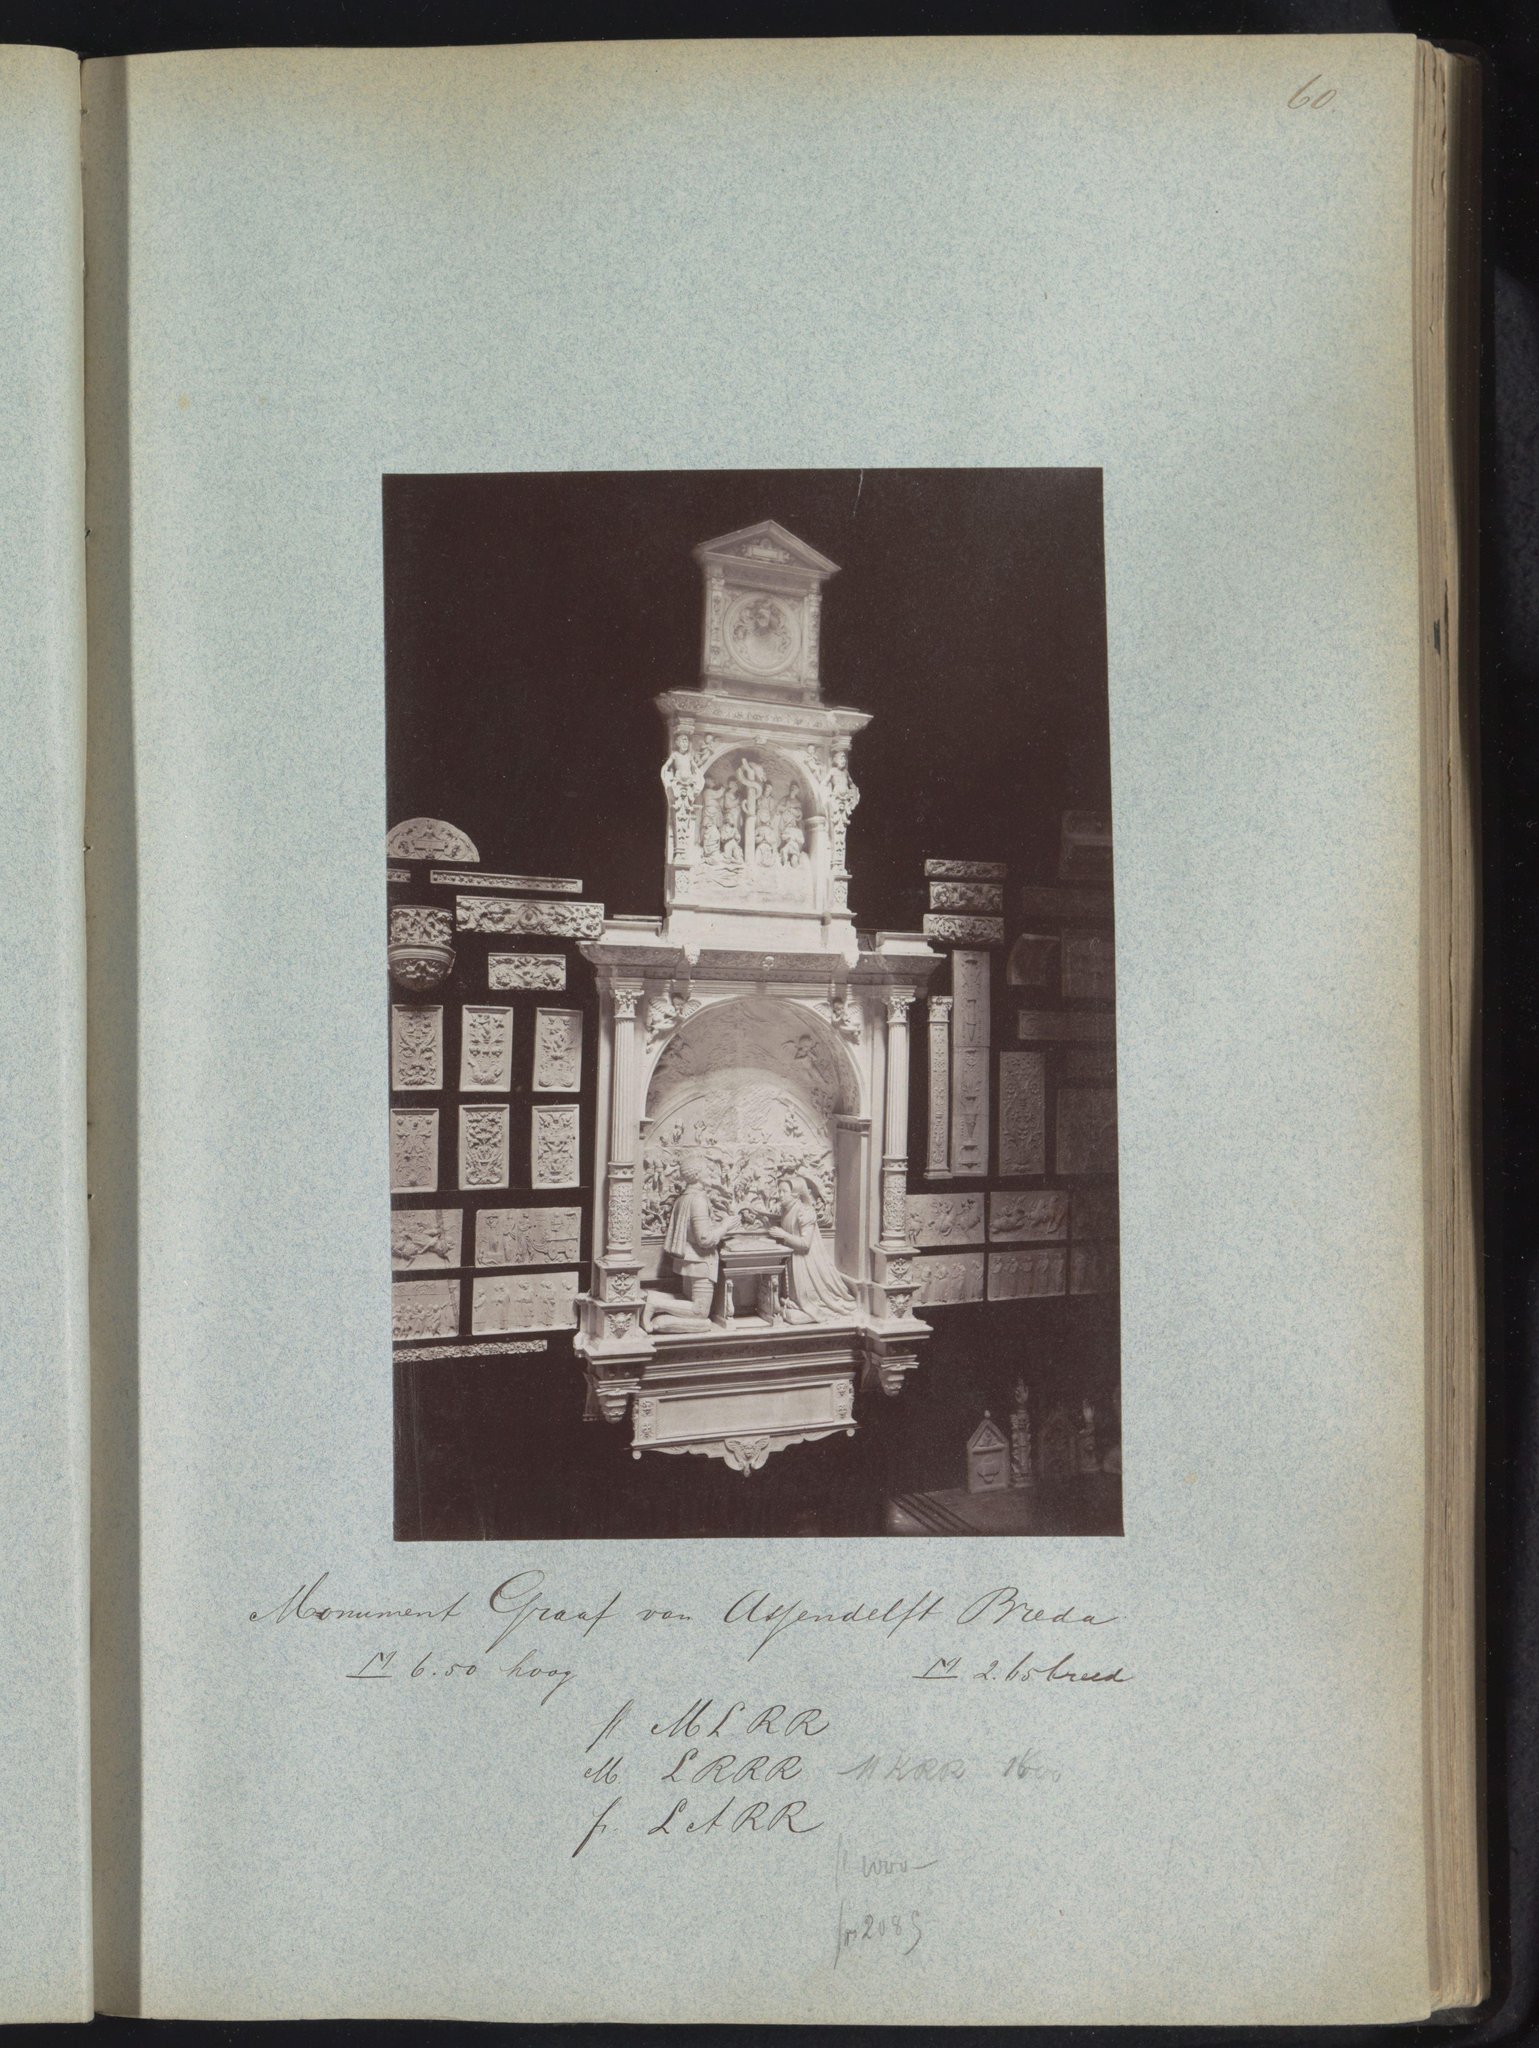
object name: album leaf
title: Gipsen afgietsel van monument van graaf van Assendelft te Breda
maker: Anonymous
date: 1875-1900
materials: paper, photographic support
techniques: albumen print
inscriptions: annotation: ‘Monument Graaf Assendelft Breda / M 6.50 hoog M 2.65 breed’, annotation